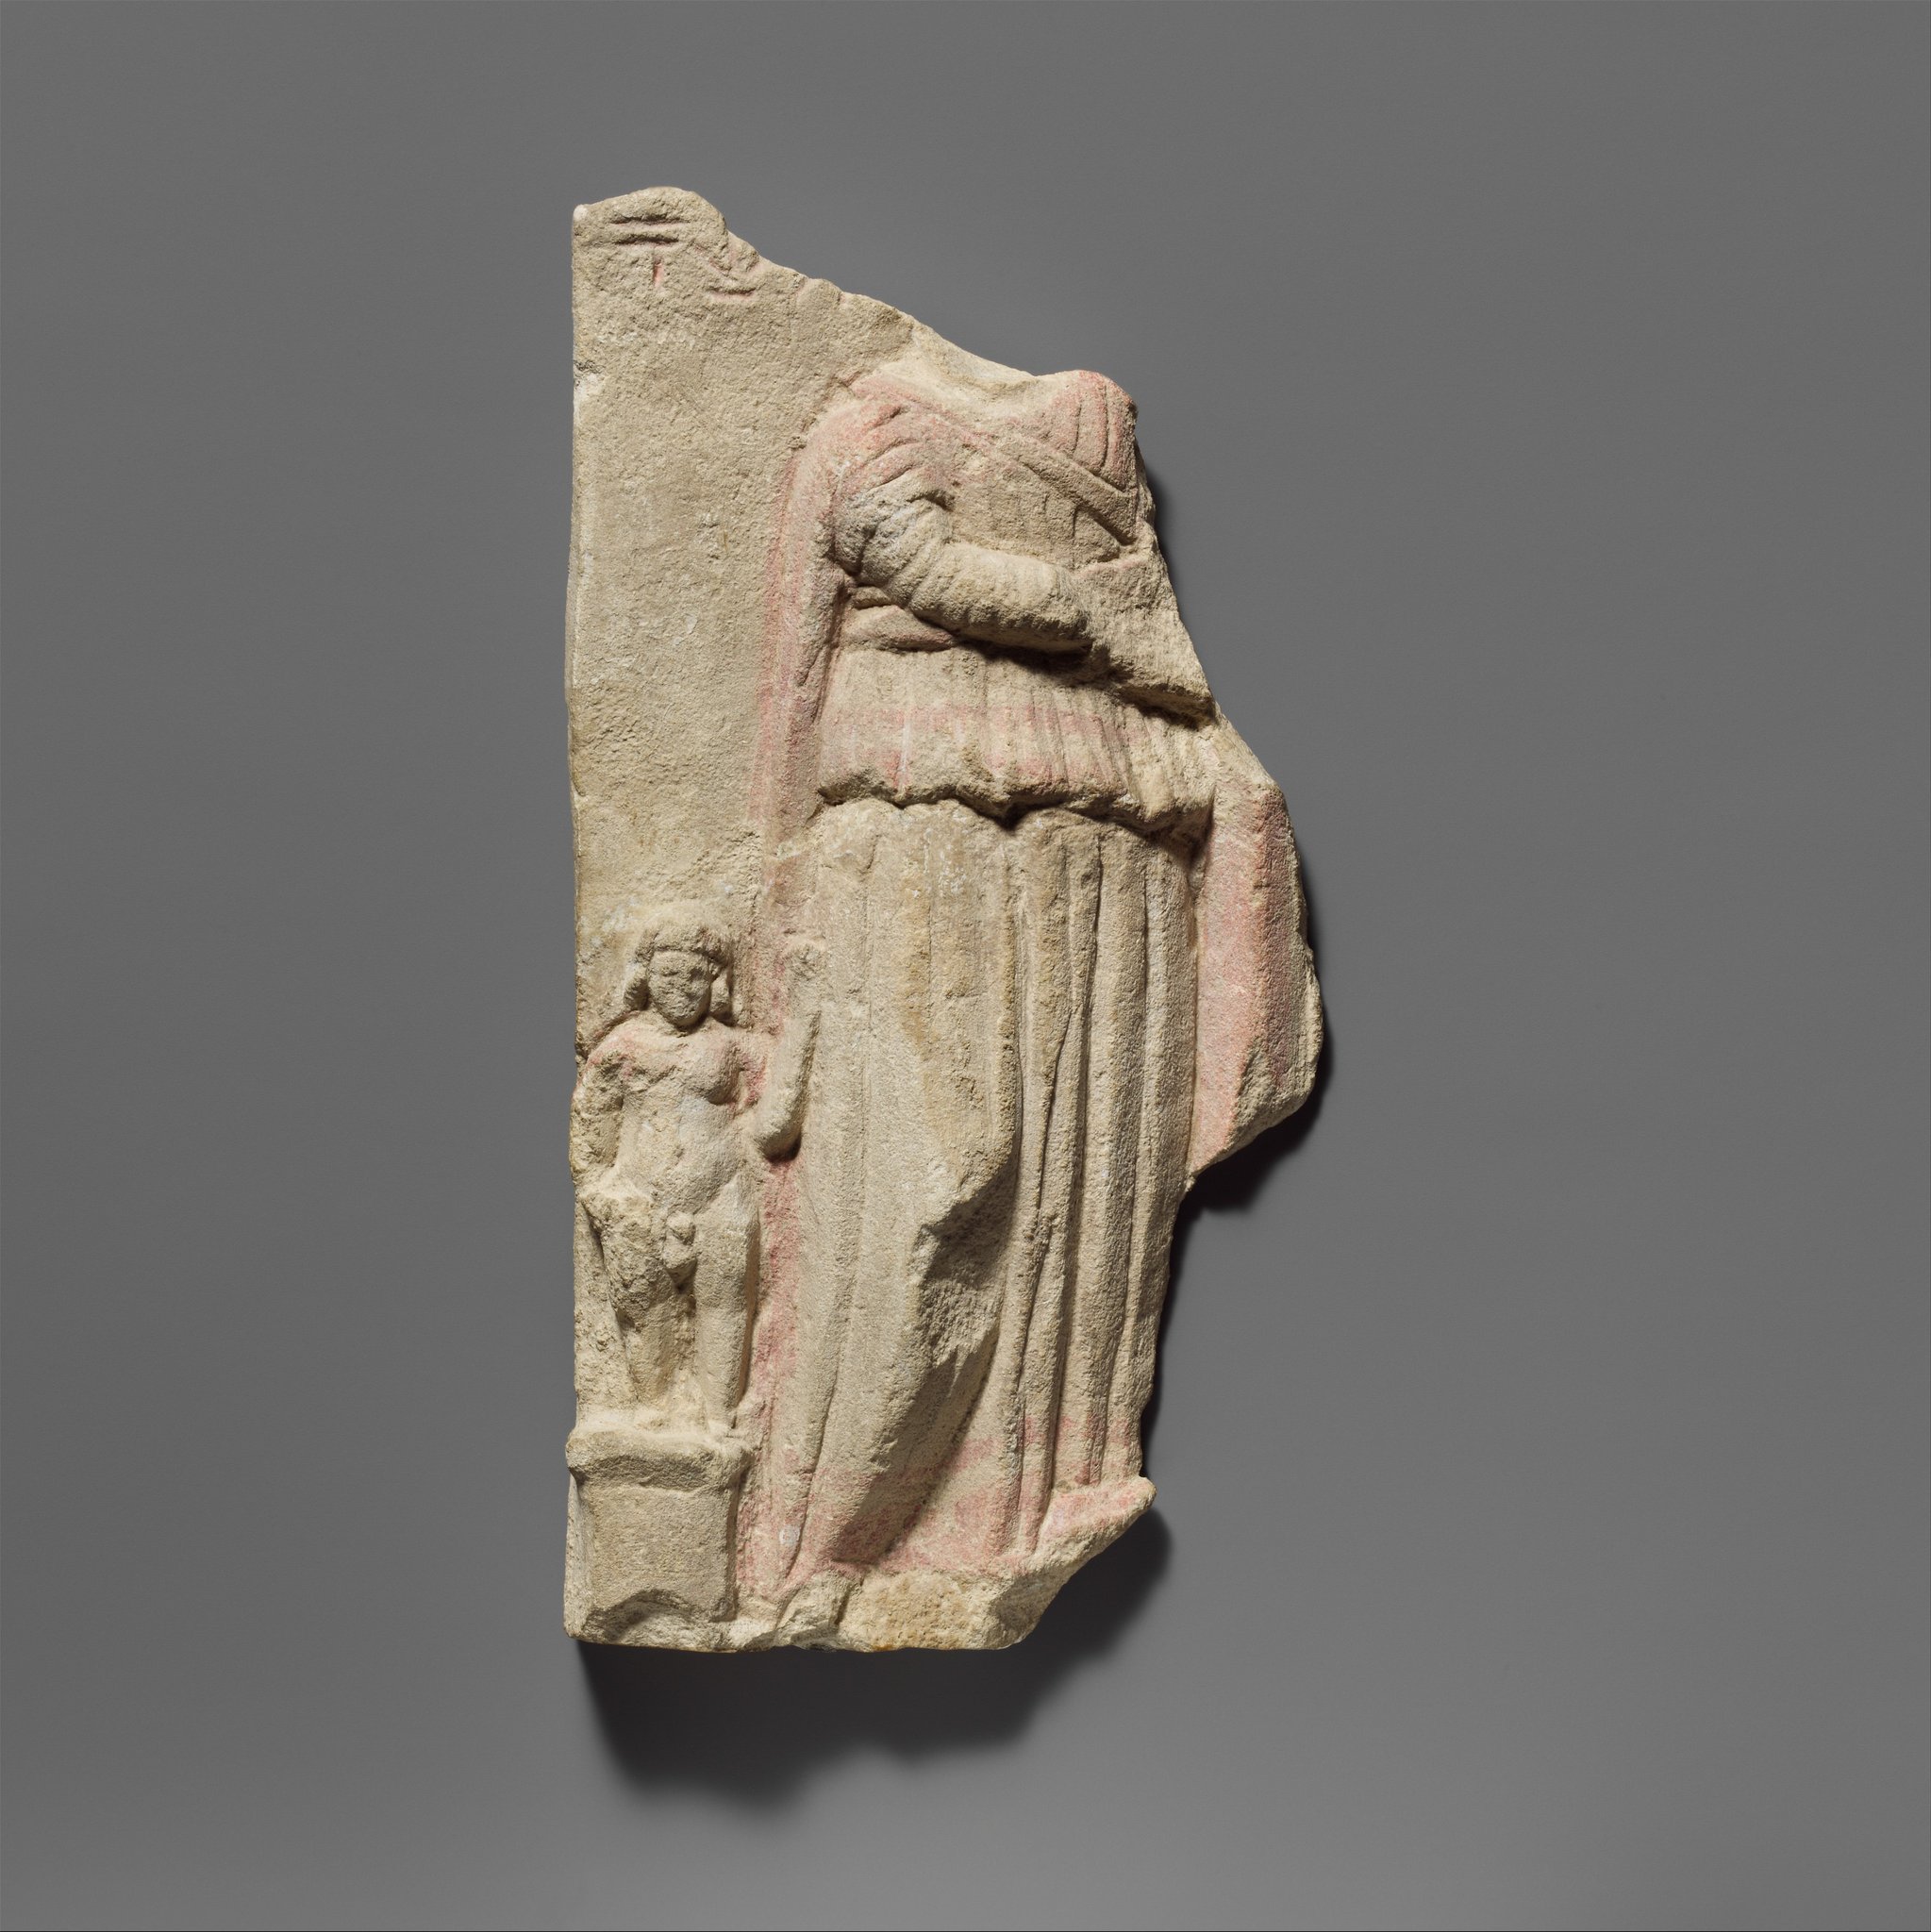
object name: relief of a woman and child, votive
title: Limestone votive relief fragment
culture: cypriot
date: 400-201 BCE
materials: limestone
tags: apollo